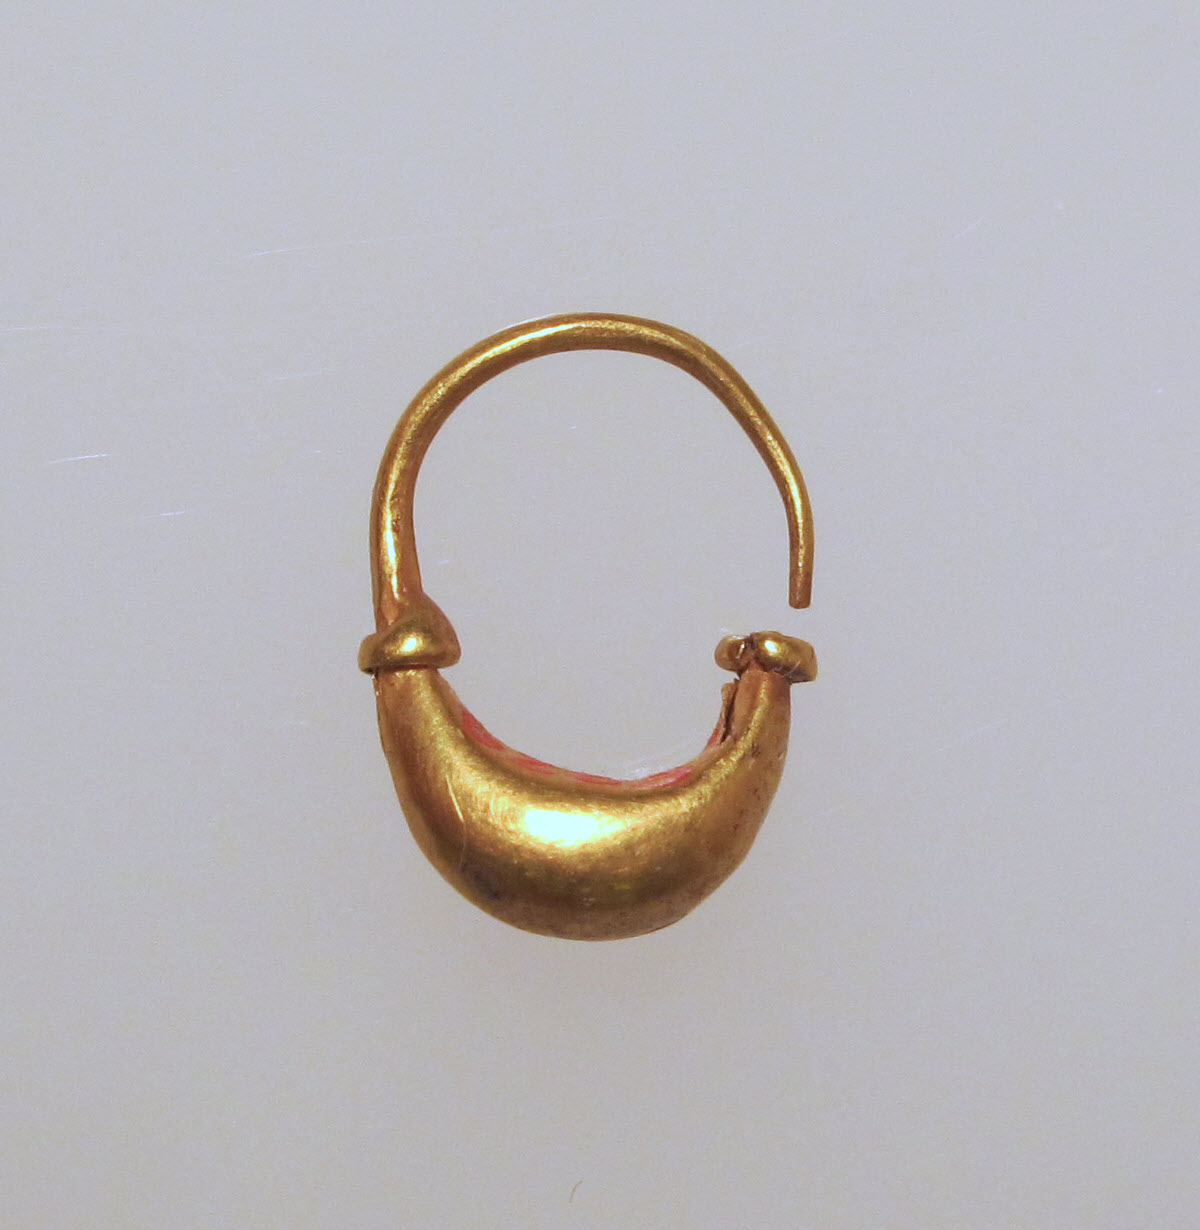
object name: earring, boat shaped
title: Earring, boat-shaped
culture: cypriot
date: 3900 BCE-100 CE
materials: gold